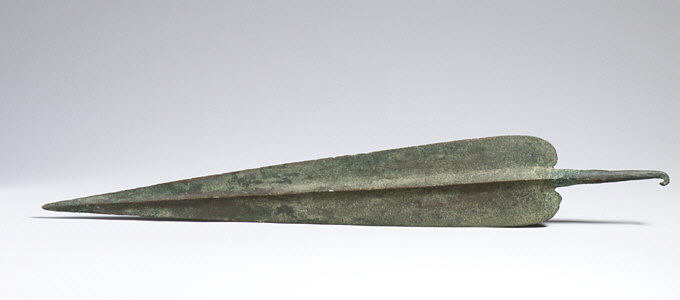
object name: dagger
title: Copper alloy spearhead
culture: cypriot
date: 2500-2000 BCE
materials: bronze